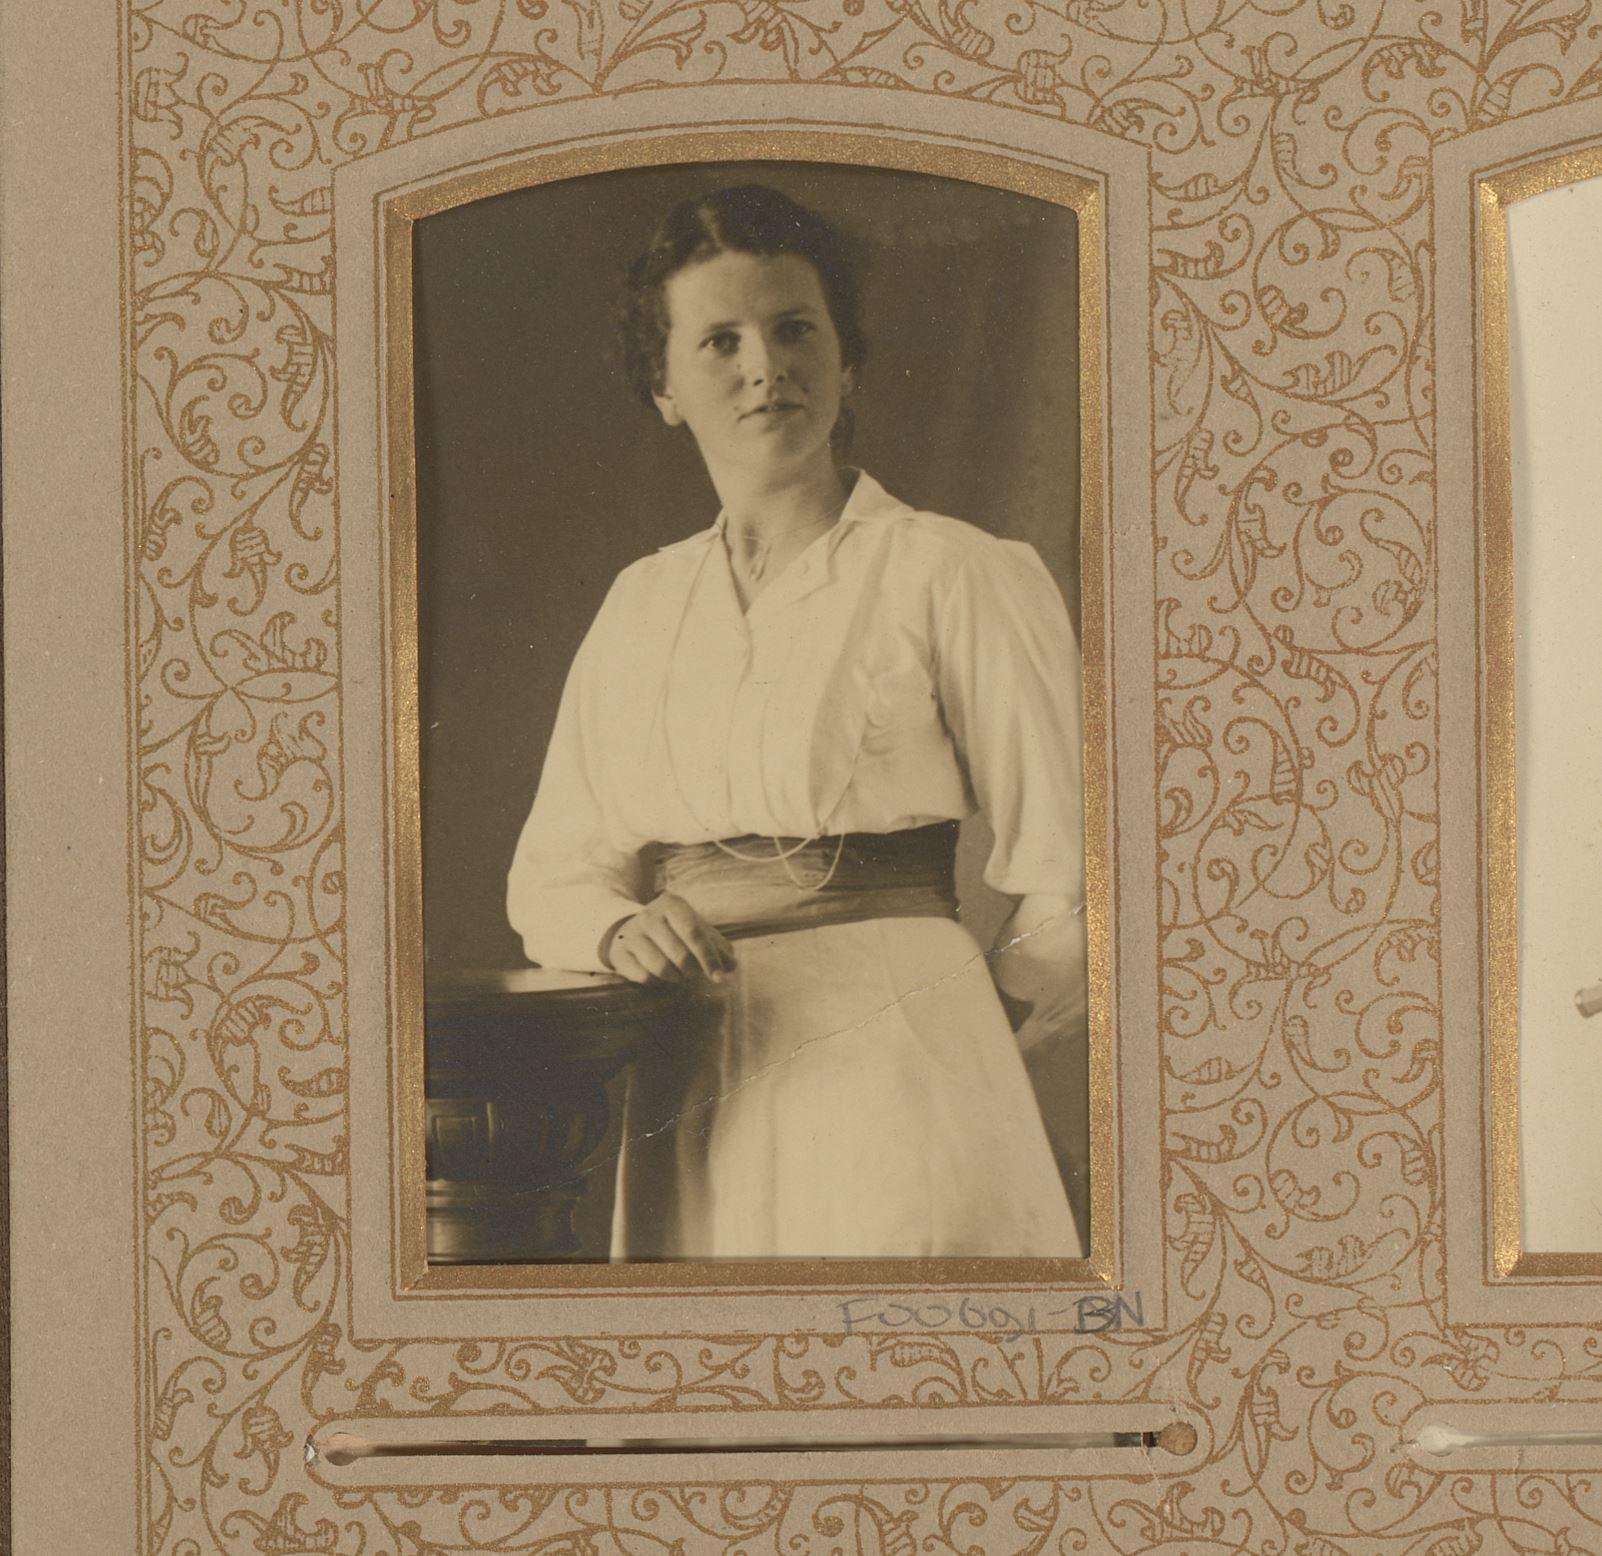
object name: album leaf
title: Portret van een jonge vrouw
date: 1917-1921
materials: photographic support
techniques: gelatin silver print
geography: the hague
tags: adolescent, young woman, maiden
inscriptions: inscription: ‘Fotografie Américaine, Wagenstraat 10/ voorheen Wagenstraat 4/ Den Haag’